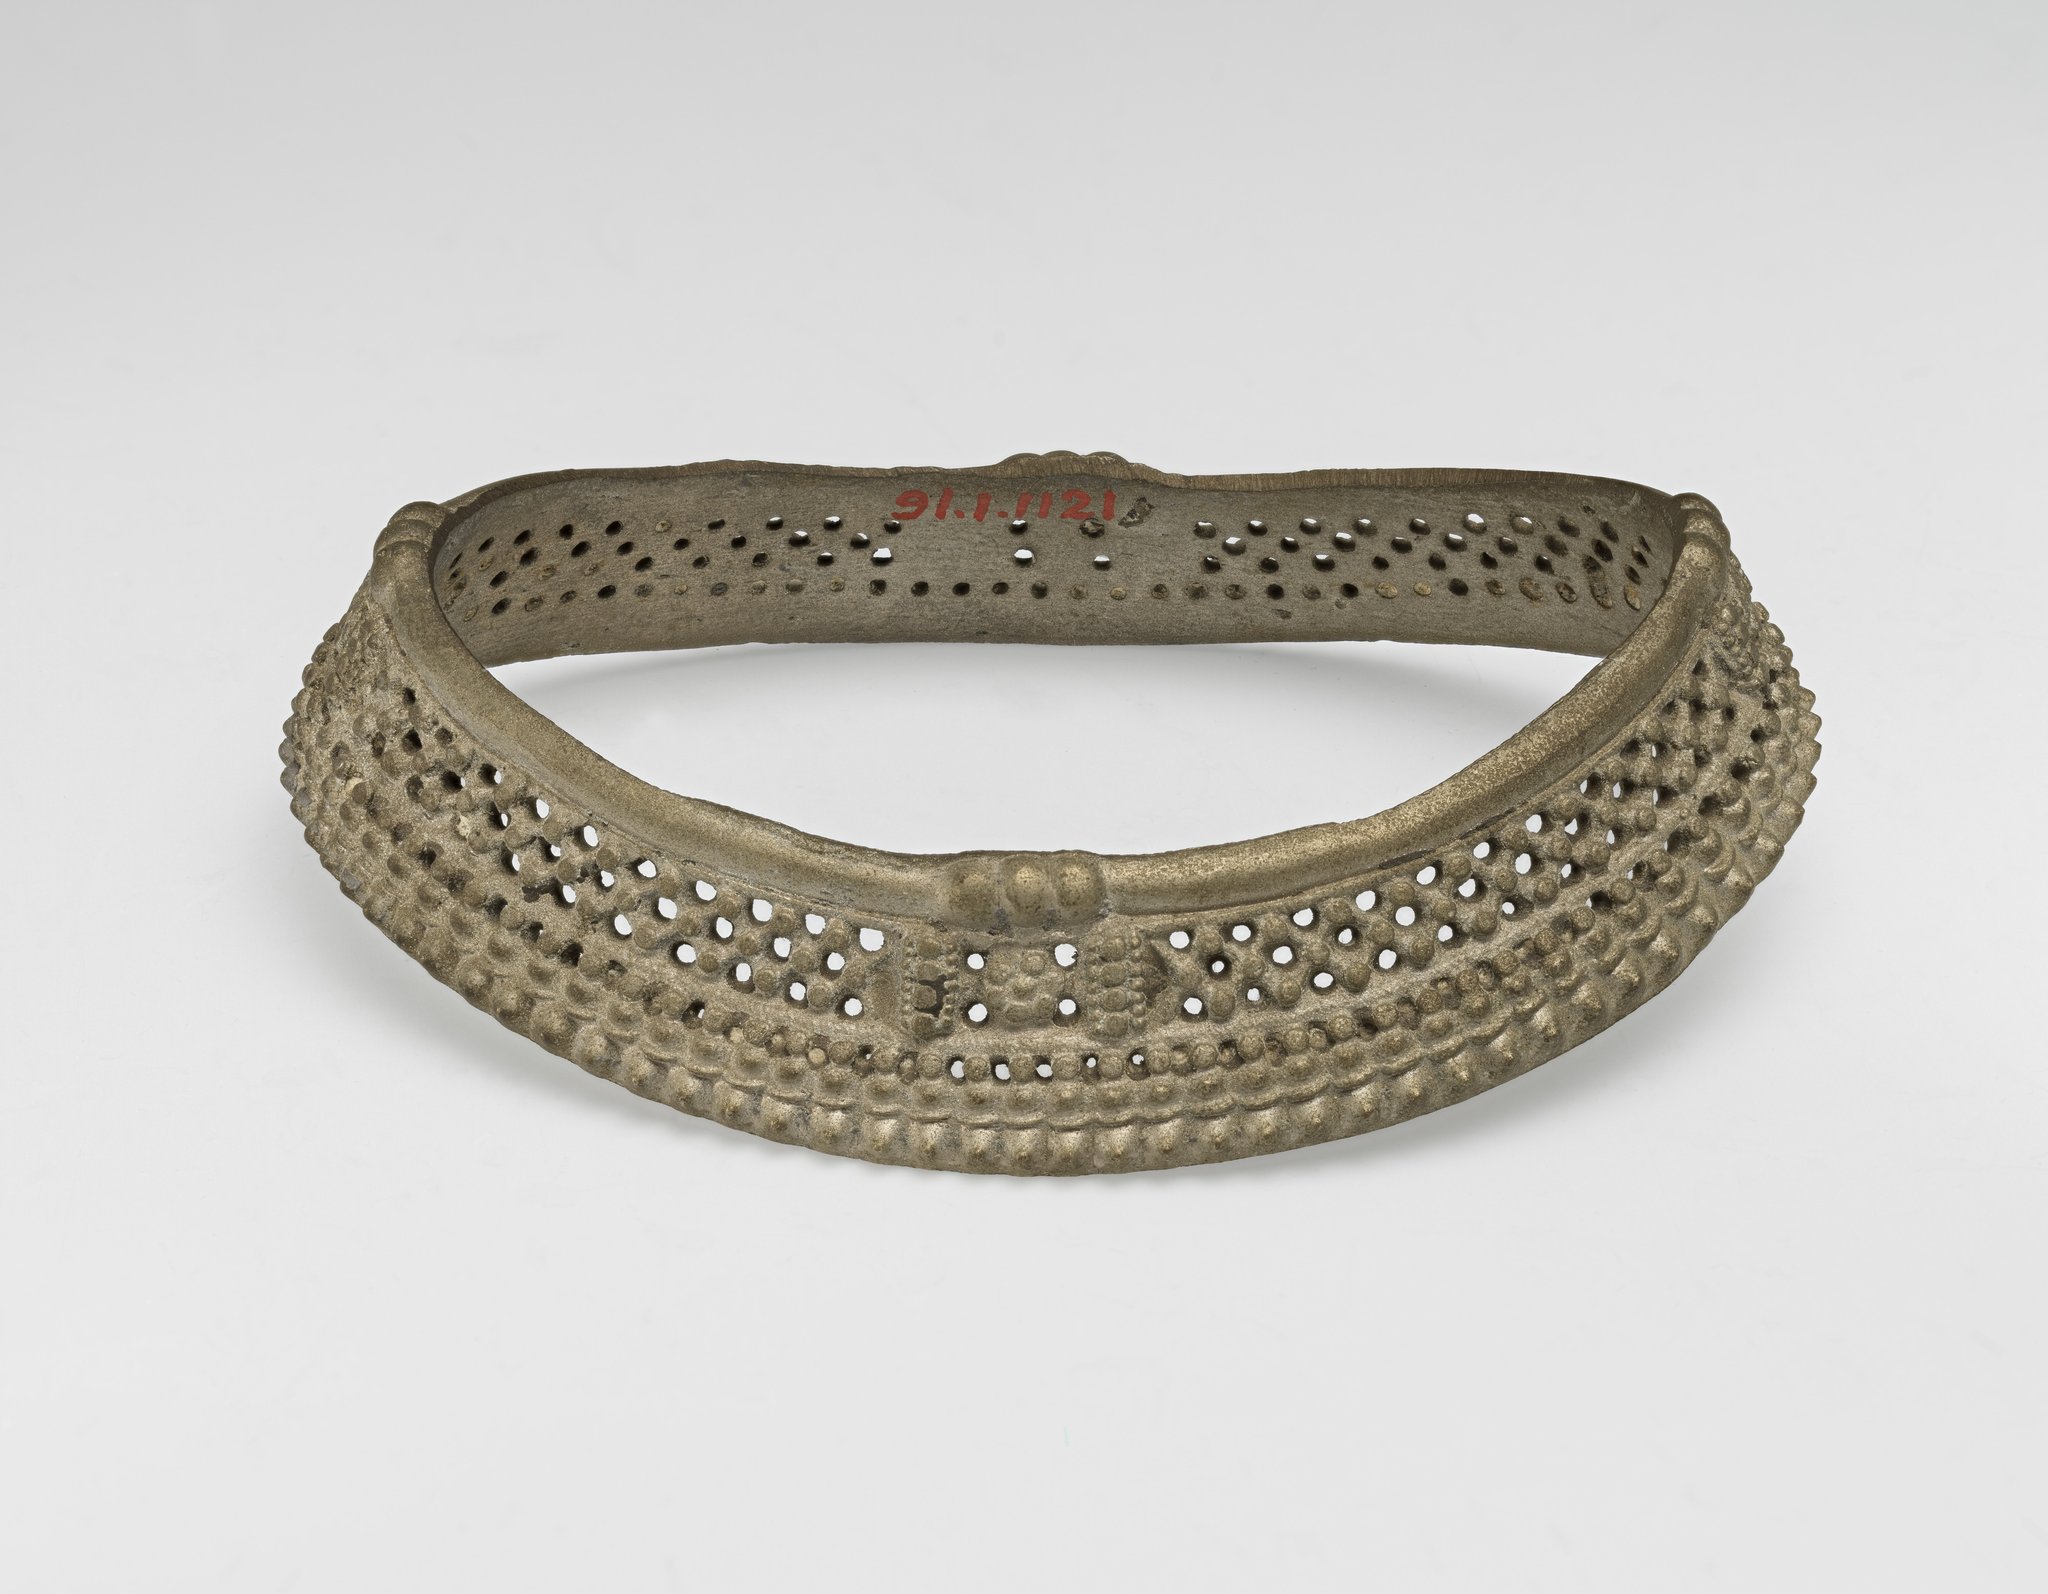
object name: anklet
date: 1801-1900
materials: iron, silver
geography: india